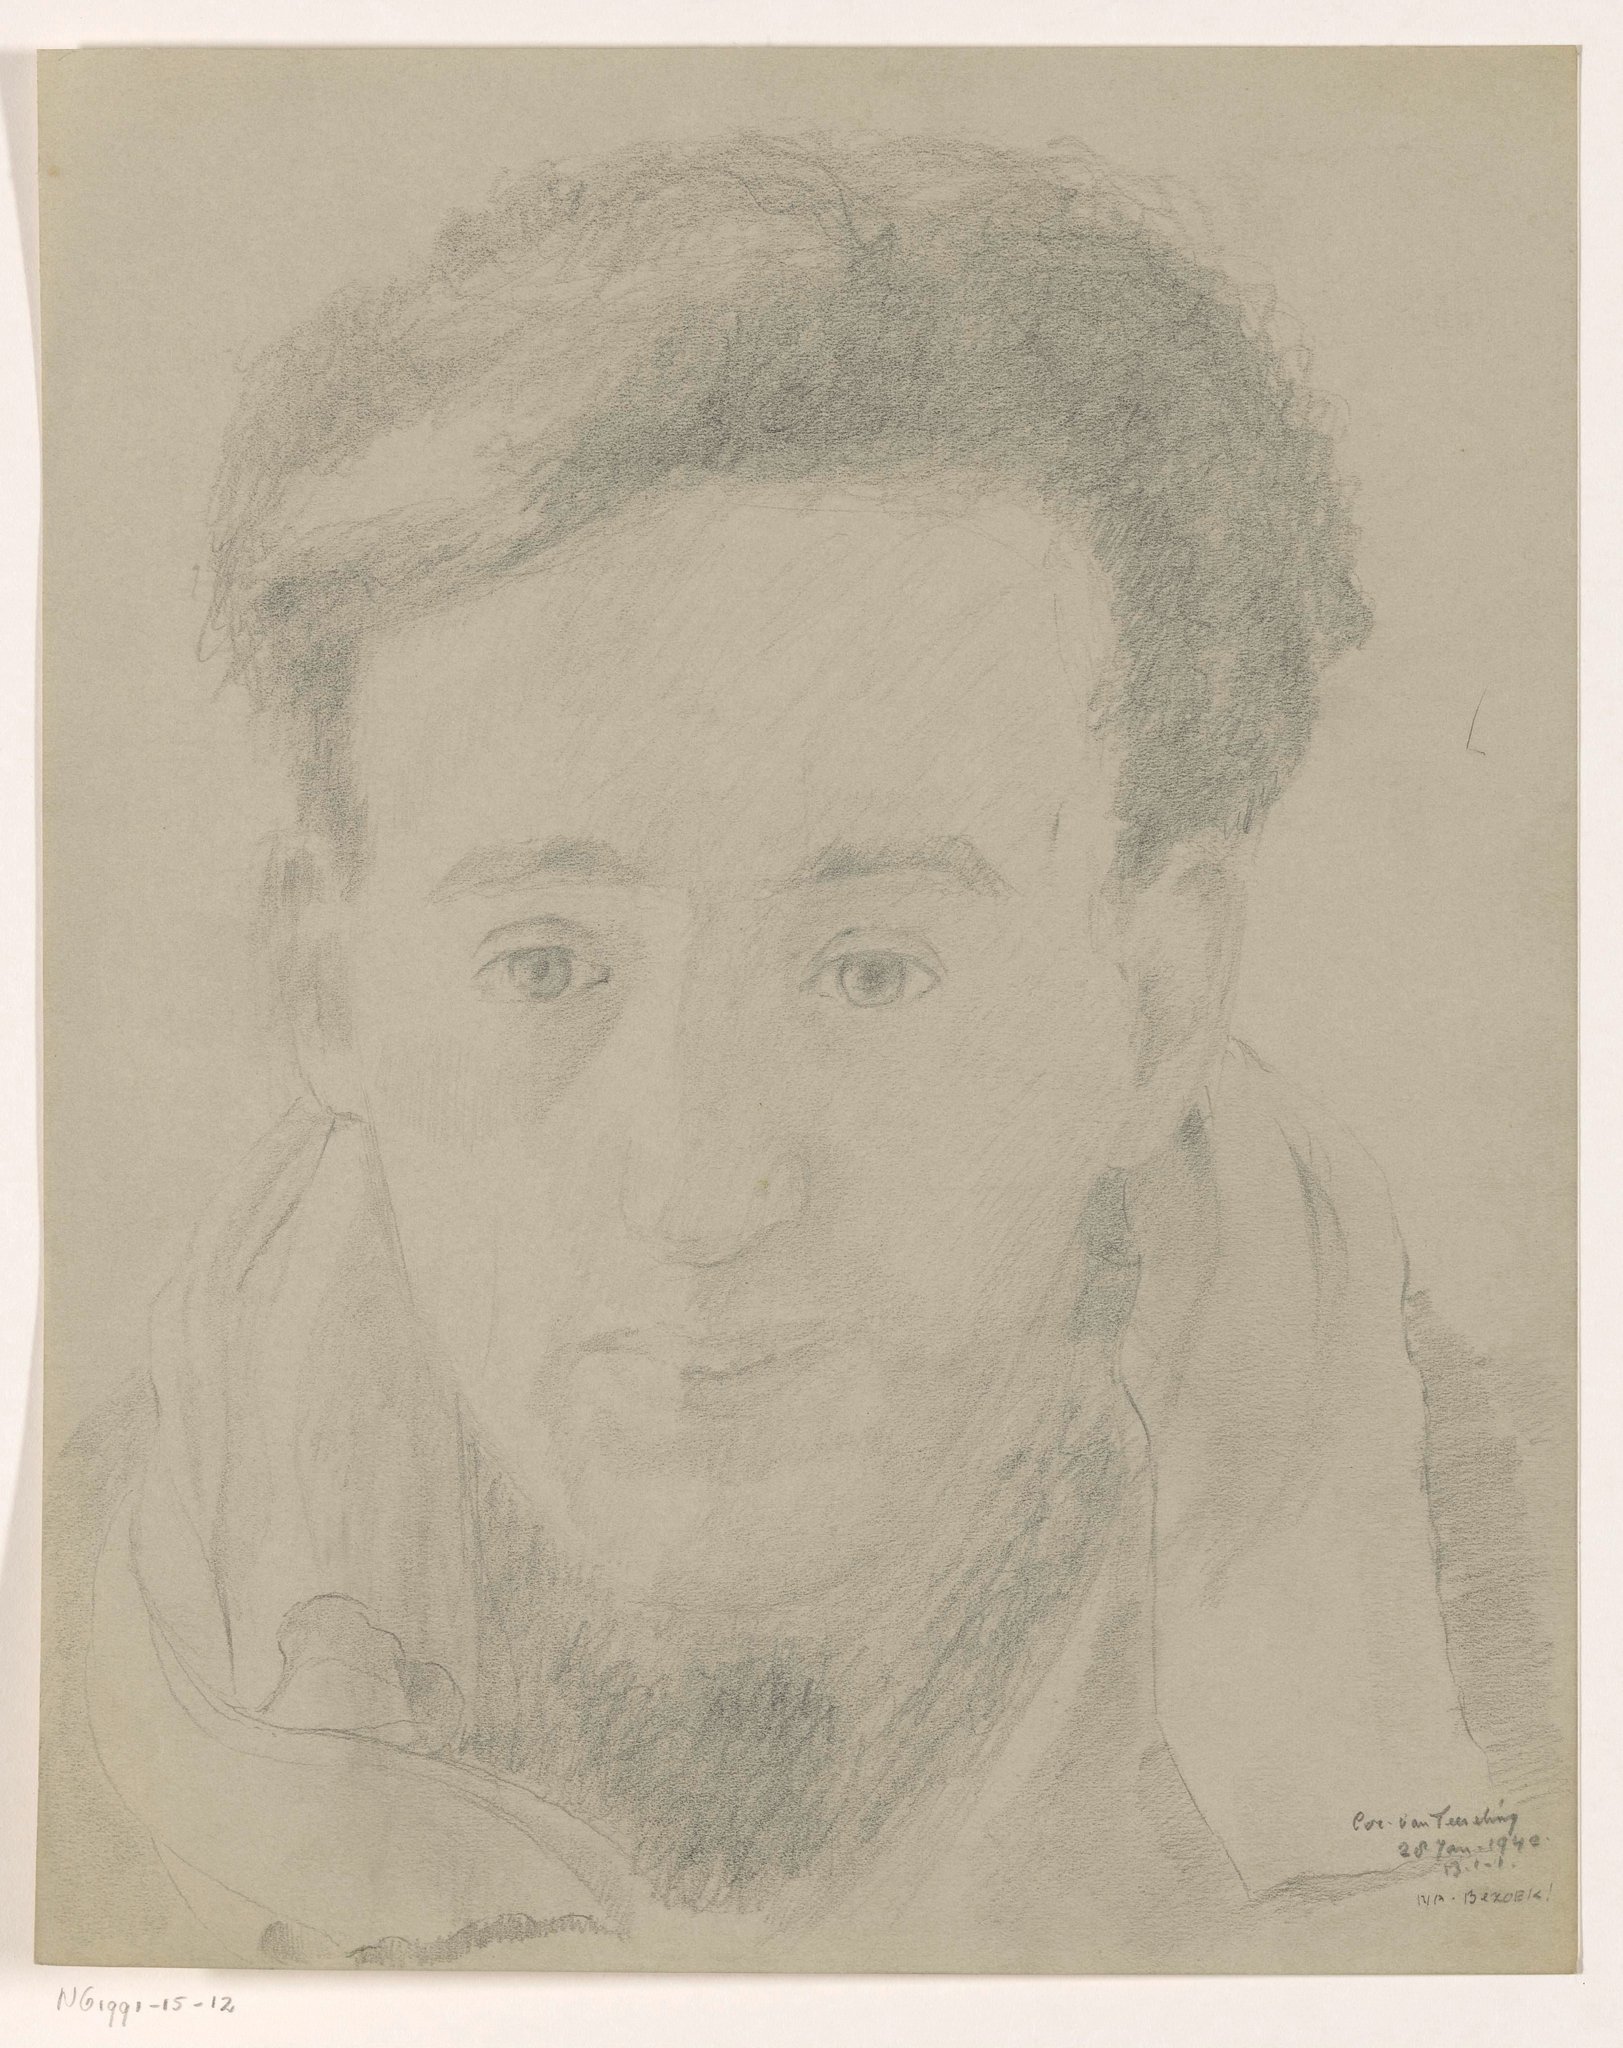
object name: drawing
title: Zelfportret en face na bezoek: B-1-1, 28 januari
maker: cor van teeseling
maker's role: draughtsman, sculptor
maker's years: 1915-1942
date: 1942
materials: paper, pencil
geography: weteringschans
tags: amsterdam, draughtsman, sculptor, cor van teeseling, portrait, self-portrait of draughtsman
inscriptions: signature and date: ‘Cor van Teeseling / 28 Jan 1942 / B-1-1 / na bezoek’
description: Getekend zelfportret van Cor van Teeseling en face na bezoek: in de gevangenis aan de Weteringschans, cel B-1-1, 28 januari.